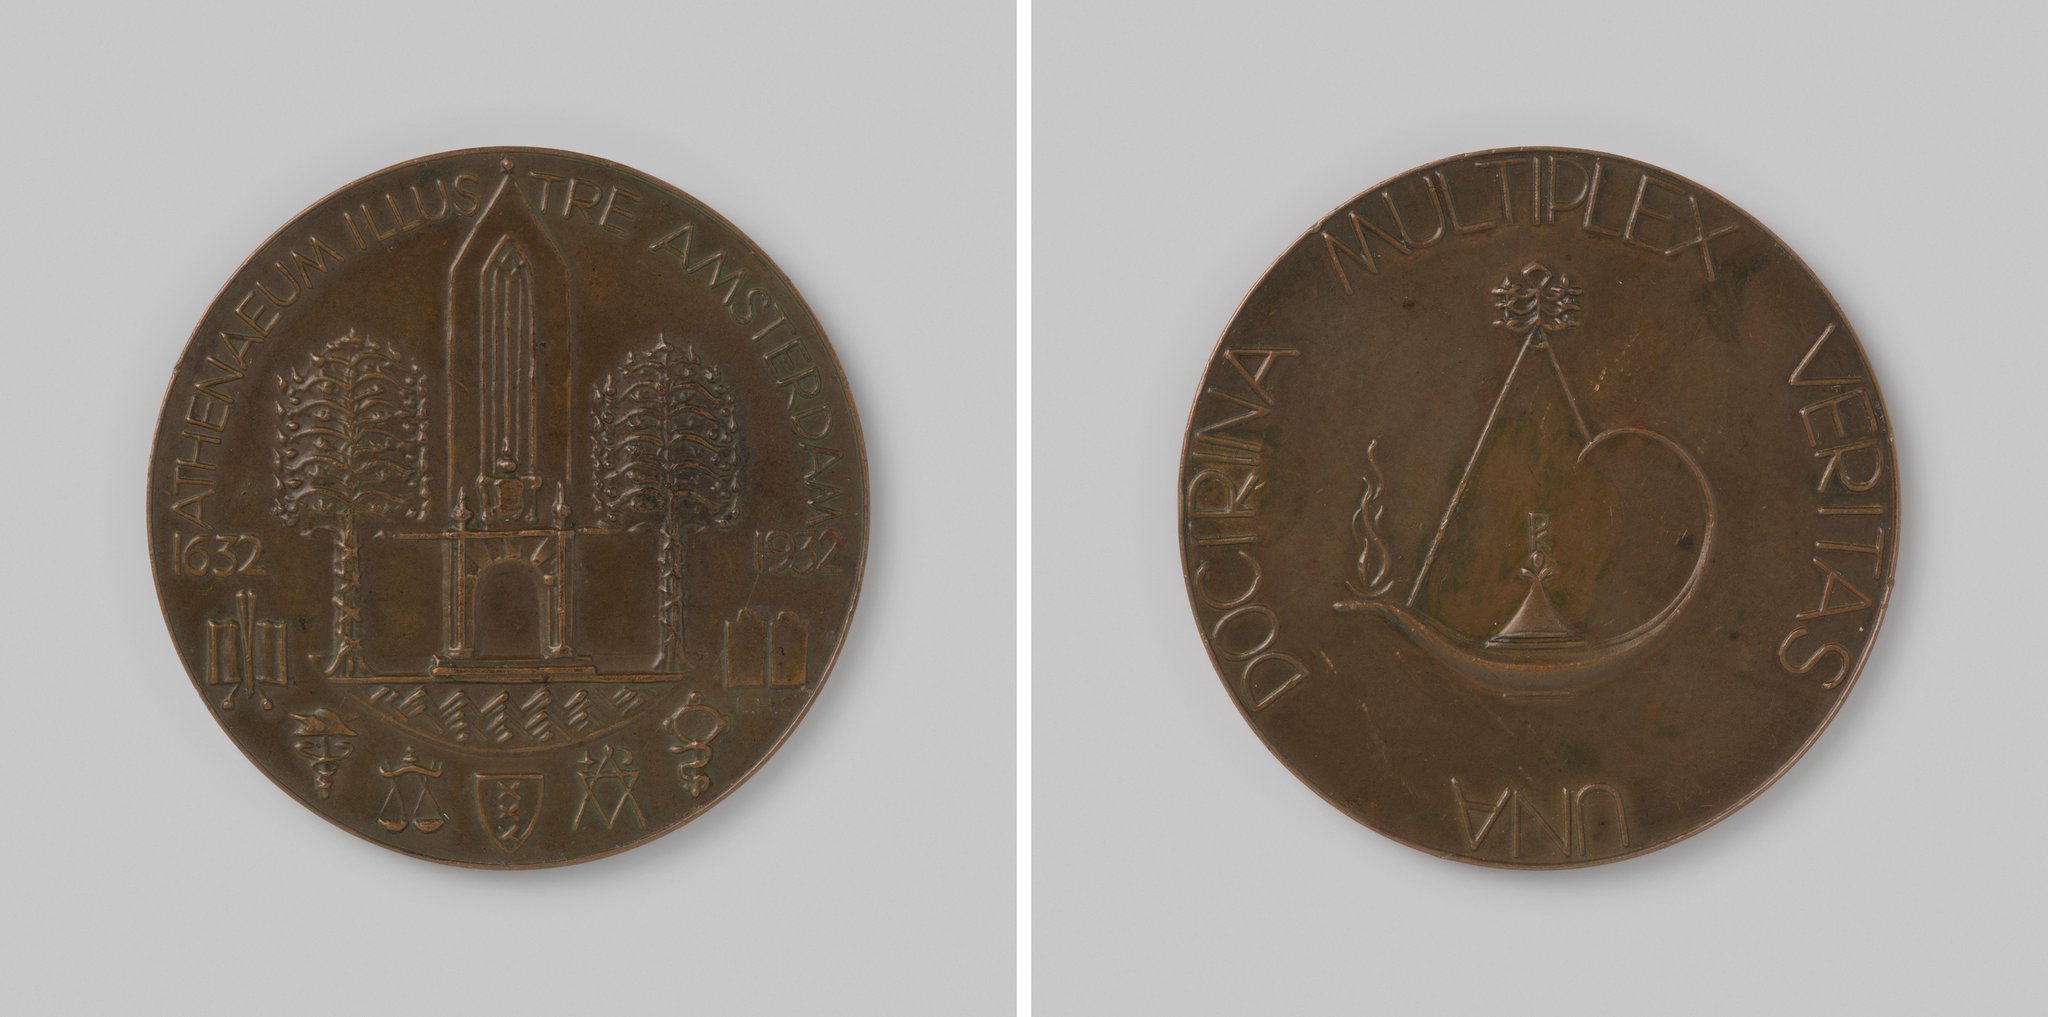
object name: history medal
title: Penning ter gelegenheid van het 300 jarig bestaan van het Athenaeum Illustre Amsterdam, 1632-1932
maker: bertus sondaar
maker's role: sculptor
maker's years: 1904-1984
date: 1932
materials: bronze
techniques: striking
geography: amsterdam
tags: amsterdam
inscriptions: inscription: ‘L.H.S.’, inscription: ‘UNA DOCTRINA MULTIPLEX VERITAS’, inscription: ‘Pk’, inscription: ‘ATHENAEUM ILLUSTRE AMSTERDAM 1632 1932’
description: Bronzen penning ter ere van het 300 jarig bestaan van het Athenaeum Illustre Amsterdam (de voorloper van de Universiteit van Amsterdam) in 1932. Voorzijde: opschrift; in het midden een poort geflankeerd door twee stylistische bomen, voorstellende de Agnieten kapel aan de Oude Zijdse Voorburgwal te Amsterdam. Hieronder een zevental tekens, voorstellende de 6 faculteiten van de universiteit. Van links naar rechts het teken van de faculteit Letteren, Economie, Rechten, het wapen van Amsterdam, de faculteit Wiskunde, Geneeskunde en Theologie. Onder het teken van de faculteit de Theologie zijn de initialen van de medailleur te onderscheiden. Keerzijde: opschrift en een olielamp-achtig object. Boven een vlammetje zijn de letters Pk (stylistisch in elkaar geschreven) te lezen.